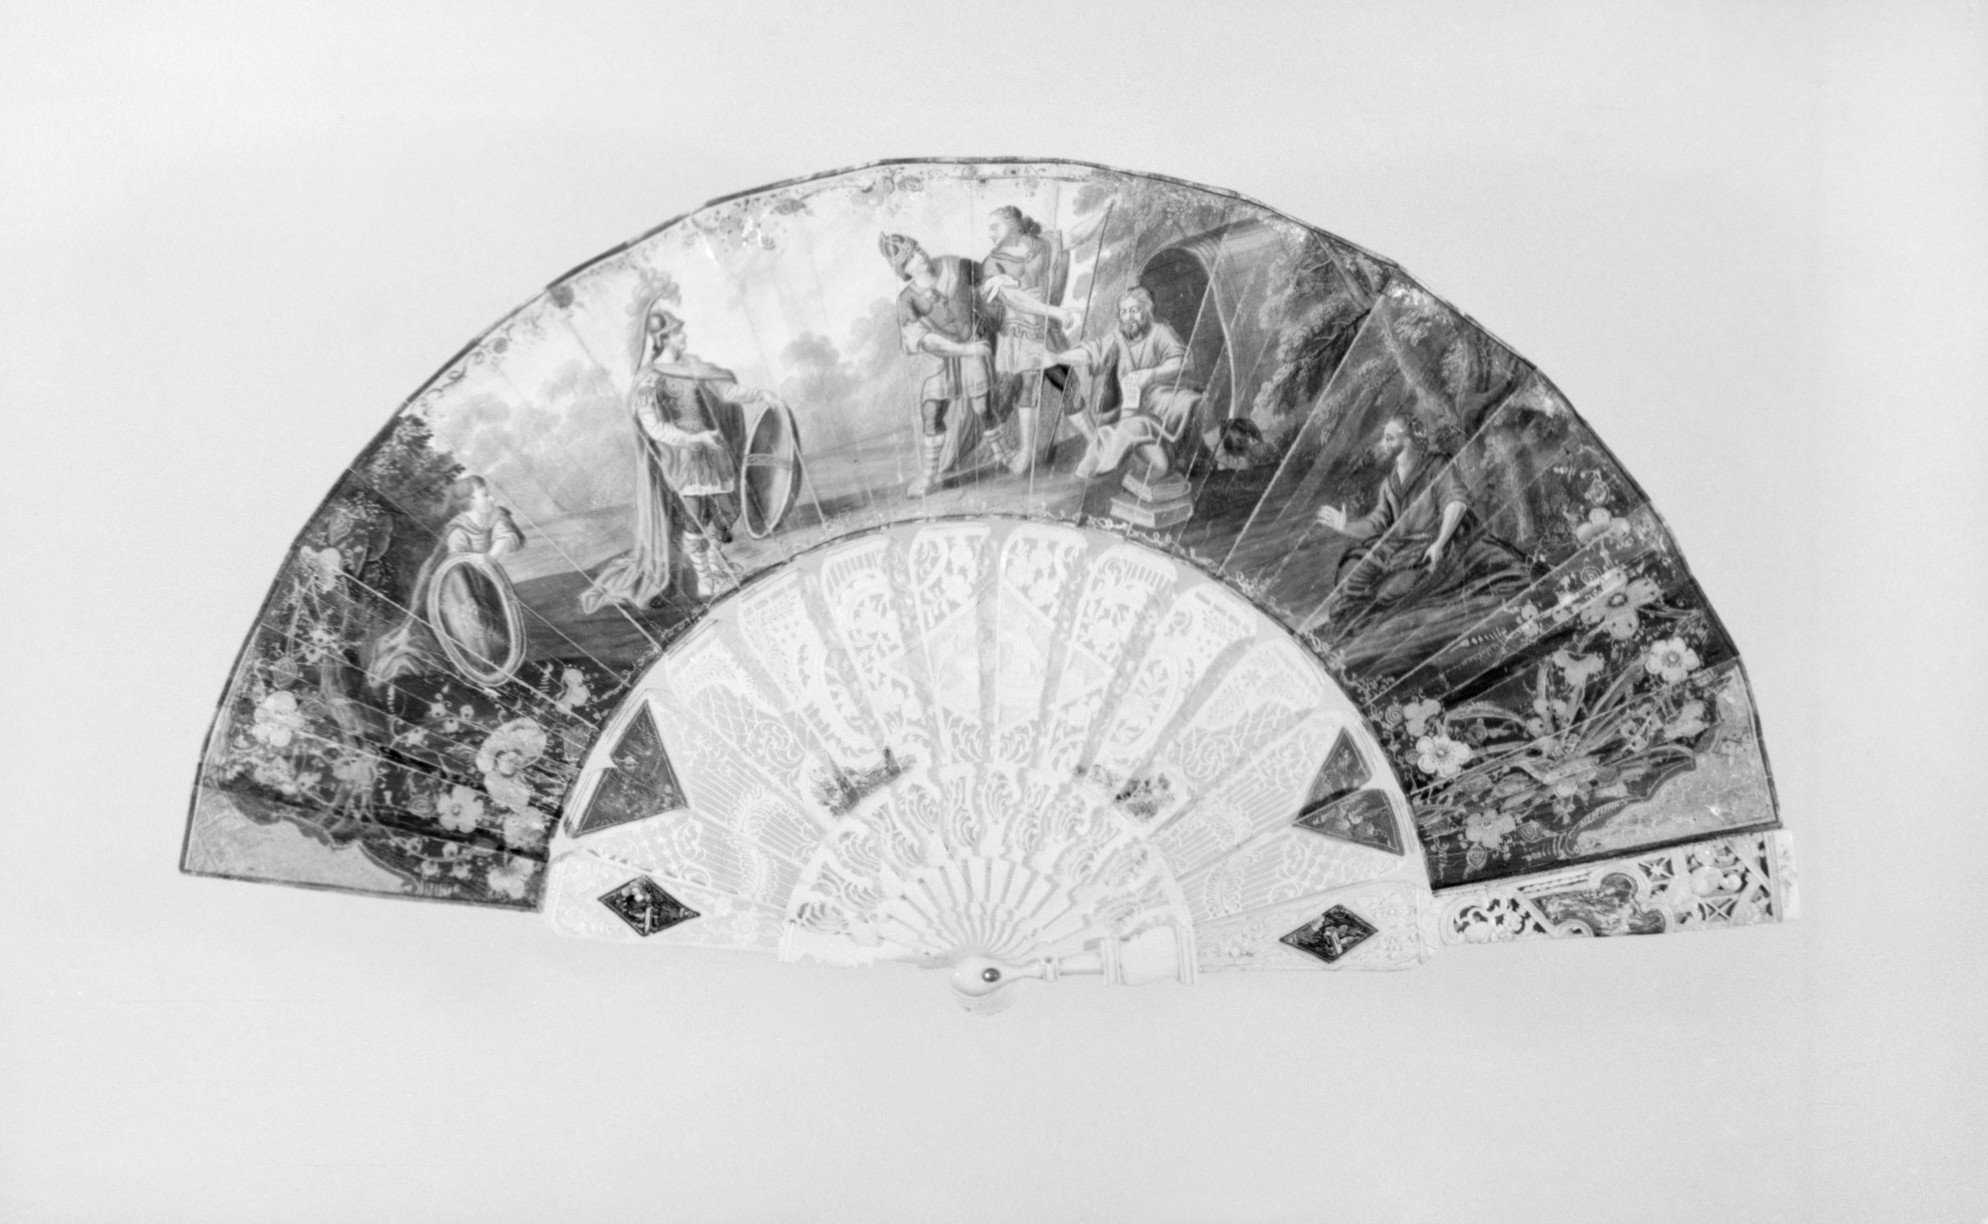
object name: fan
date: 1701-1800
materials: ivory, paper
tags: shields,men